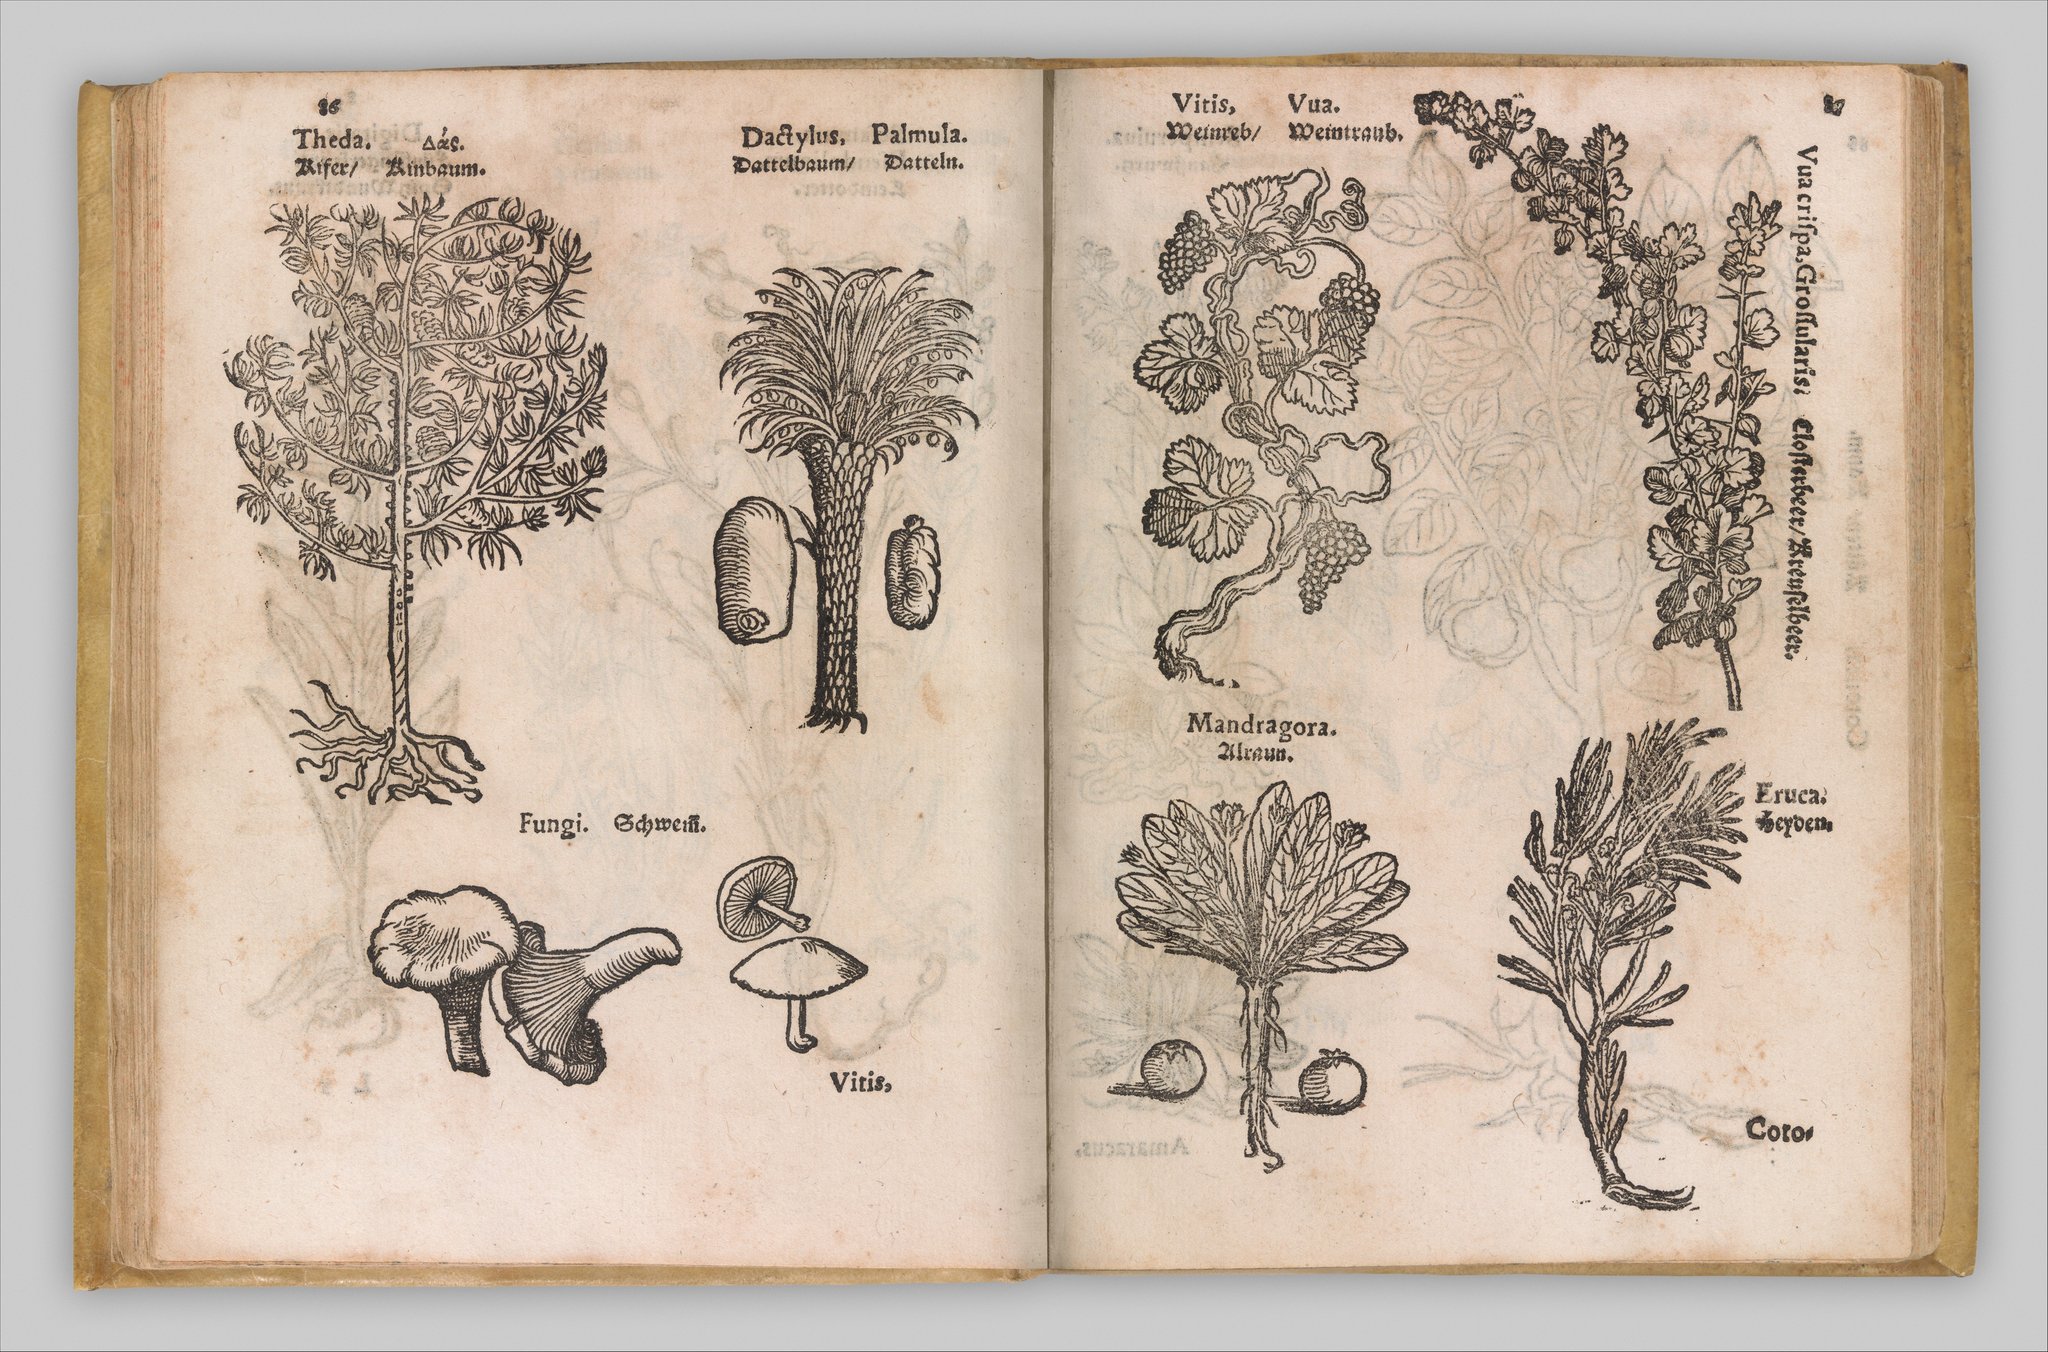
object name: book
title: I) Herbarum, Arborum, Fructium, Frumentorum, c. 1540 ... II) De Speciali quarundam plantarum, Frankfurt: Egenolff 1552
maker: christian egenolff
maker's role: printer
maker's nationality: german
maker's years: 1502-1555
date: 1552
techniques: woodcut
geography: germany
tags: grapes,plants,herbs,trees